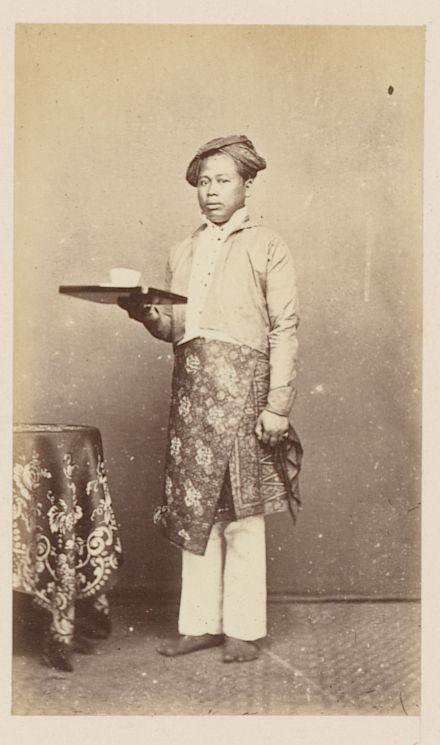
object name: photograph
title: Portret van een Indische bediende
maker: Anonymous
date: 1880-1883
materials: photographic support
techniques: albumen print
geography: dutch east indies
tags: studio requisites ~ photographer, adult man, house personnel, servants, dutch east indies, the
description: Onderdeel van Reisalbum met opnames van bezienswaardigheden in Egypte, Nederlands-Indië, Singapore en Ceylon.